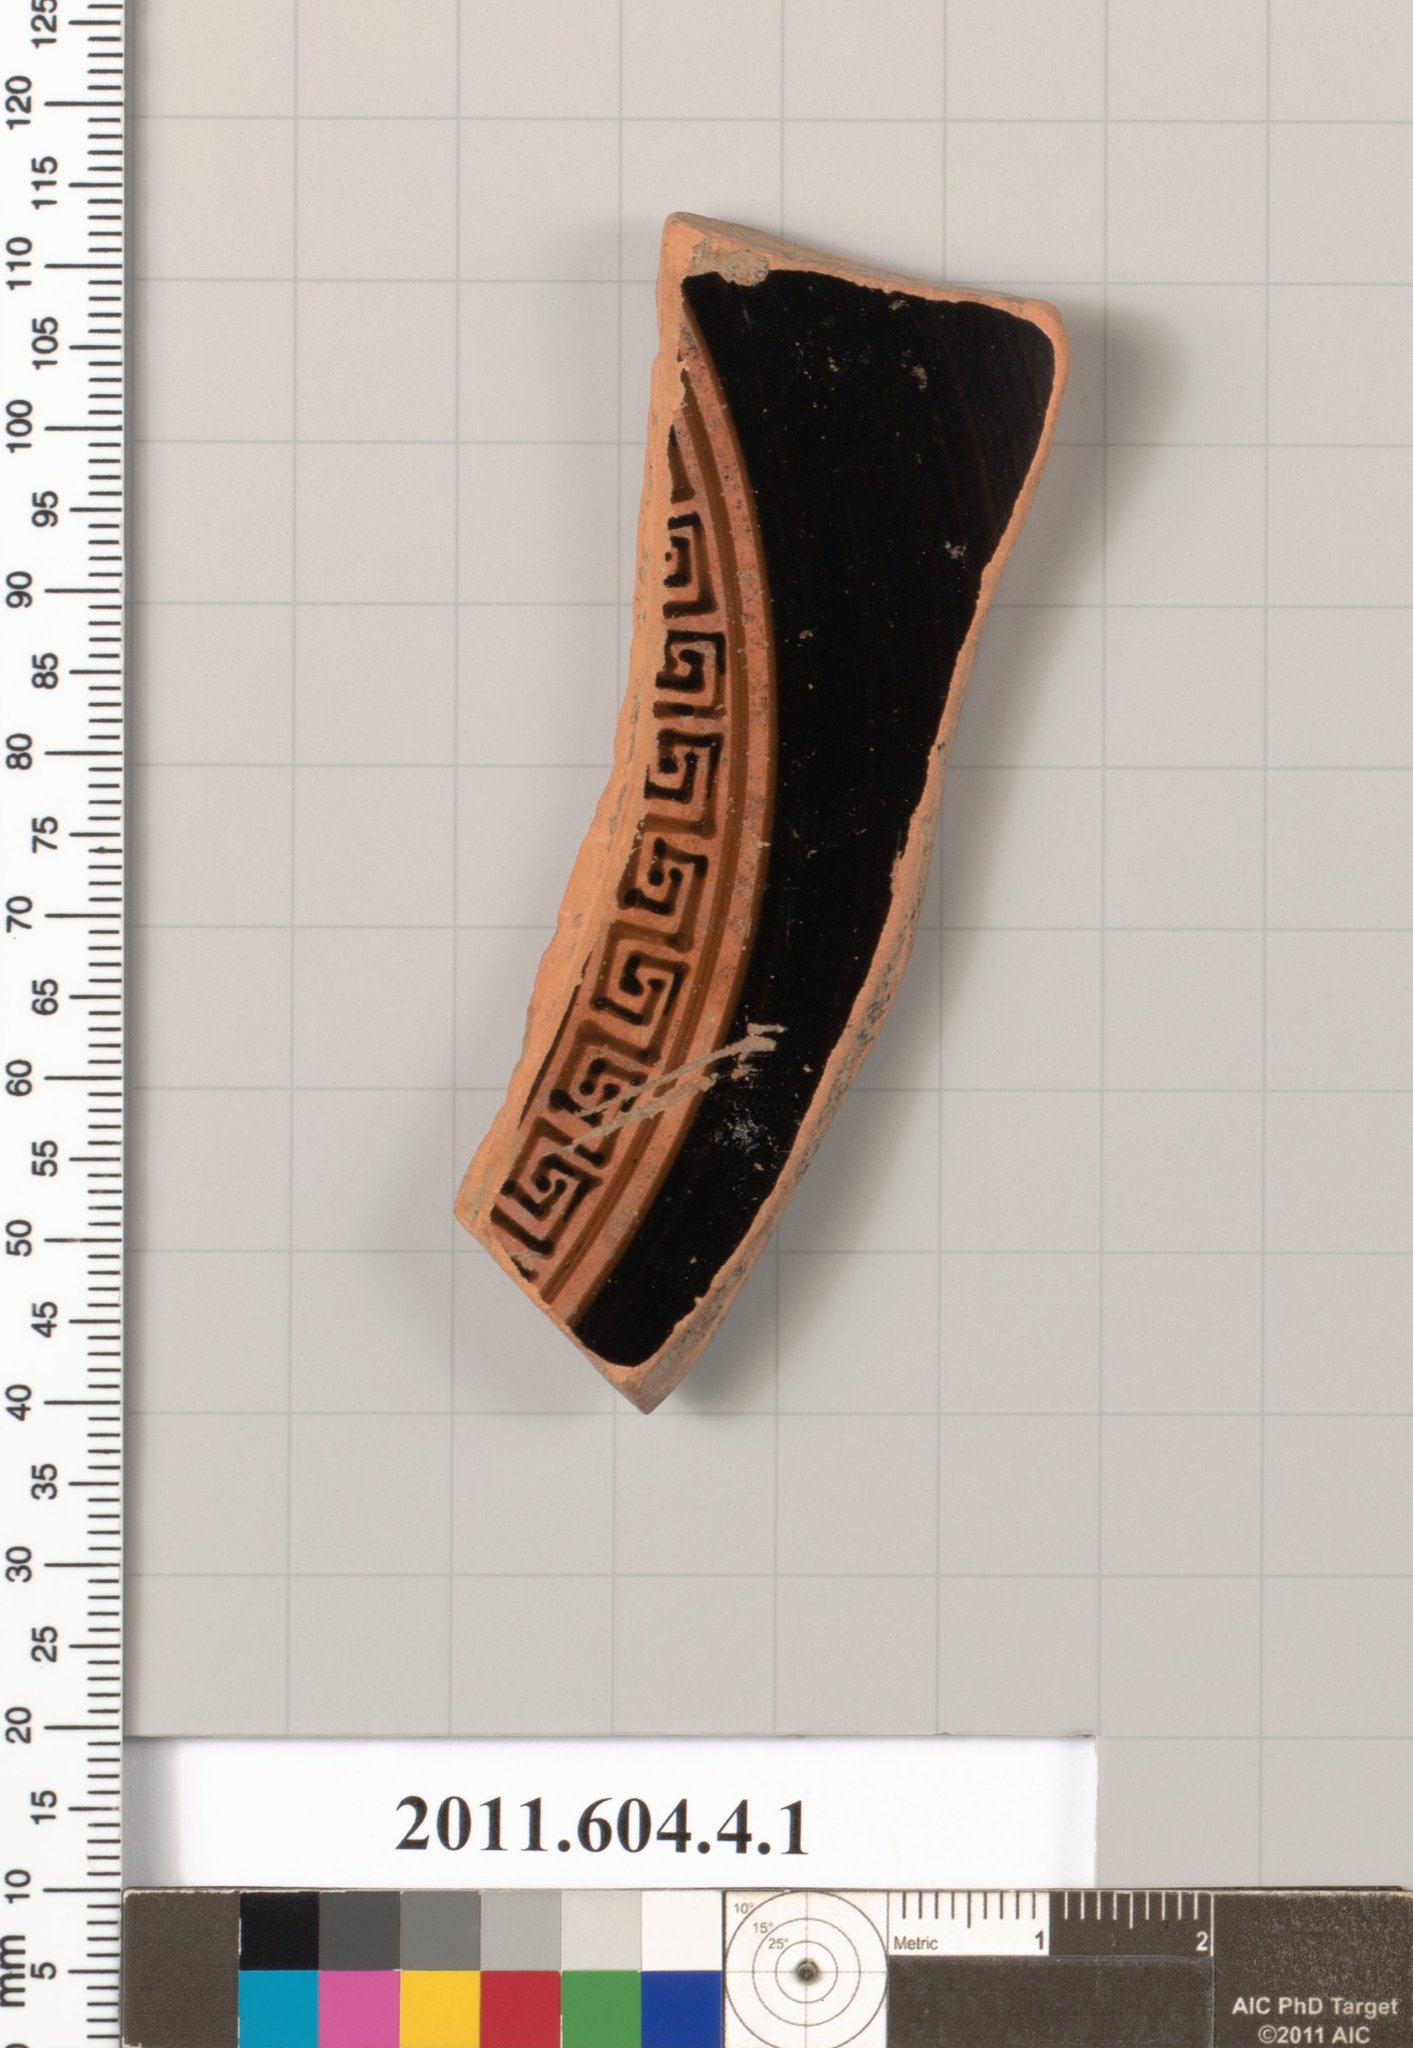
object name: kylix fragment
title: Terracotta fragment of a kylix (drinking cup)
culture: greek, attic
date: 480 BCE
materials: terracotta